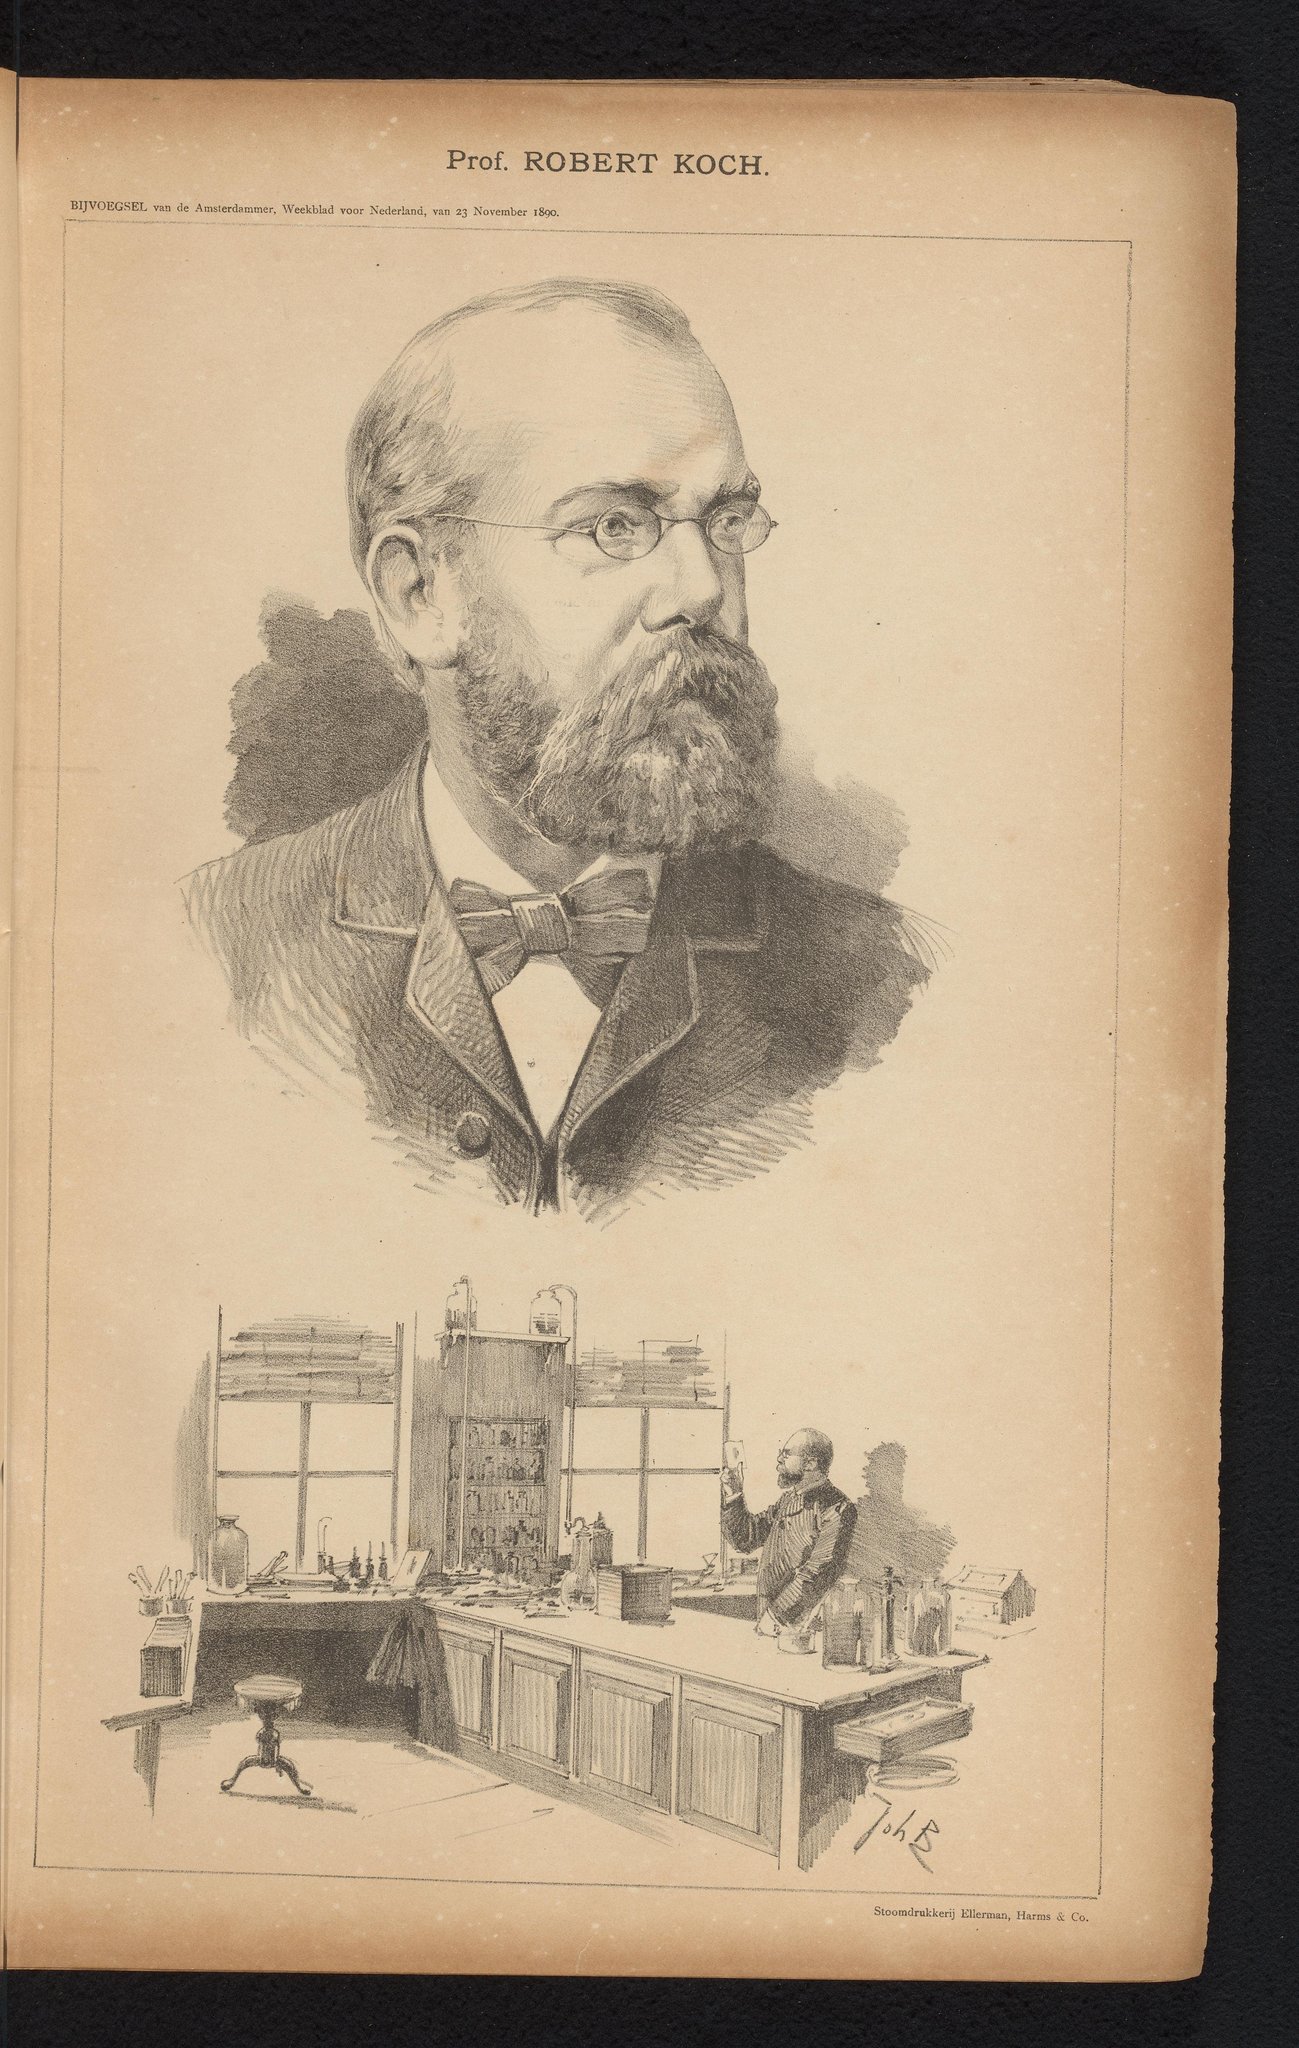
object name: print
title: Prof Robert Koch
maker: johan braakensiek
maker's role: draughtsman, print maker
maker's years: 1858-1940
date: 1890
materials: paper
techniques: lithograph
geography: amsterdam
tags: historical persons, bacteriology (+ scholar, scientist (at work)), physician, doctor, laboratory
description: Portret van de Duitse medicus en microbioloog Robert Koch. Boven een portret, onder de arts in zijn laboratorium.